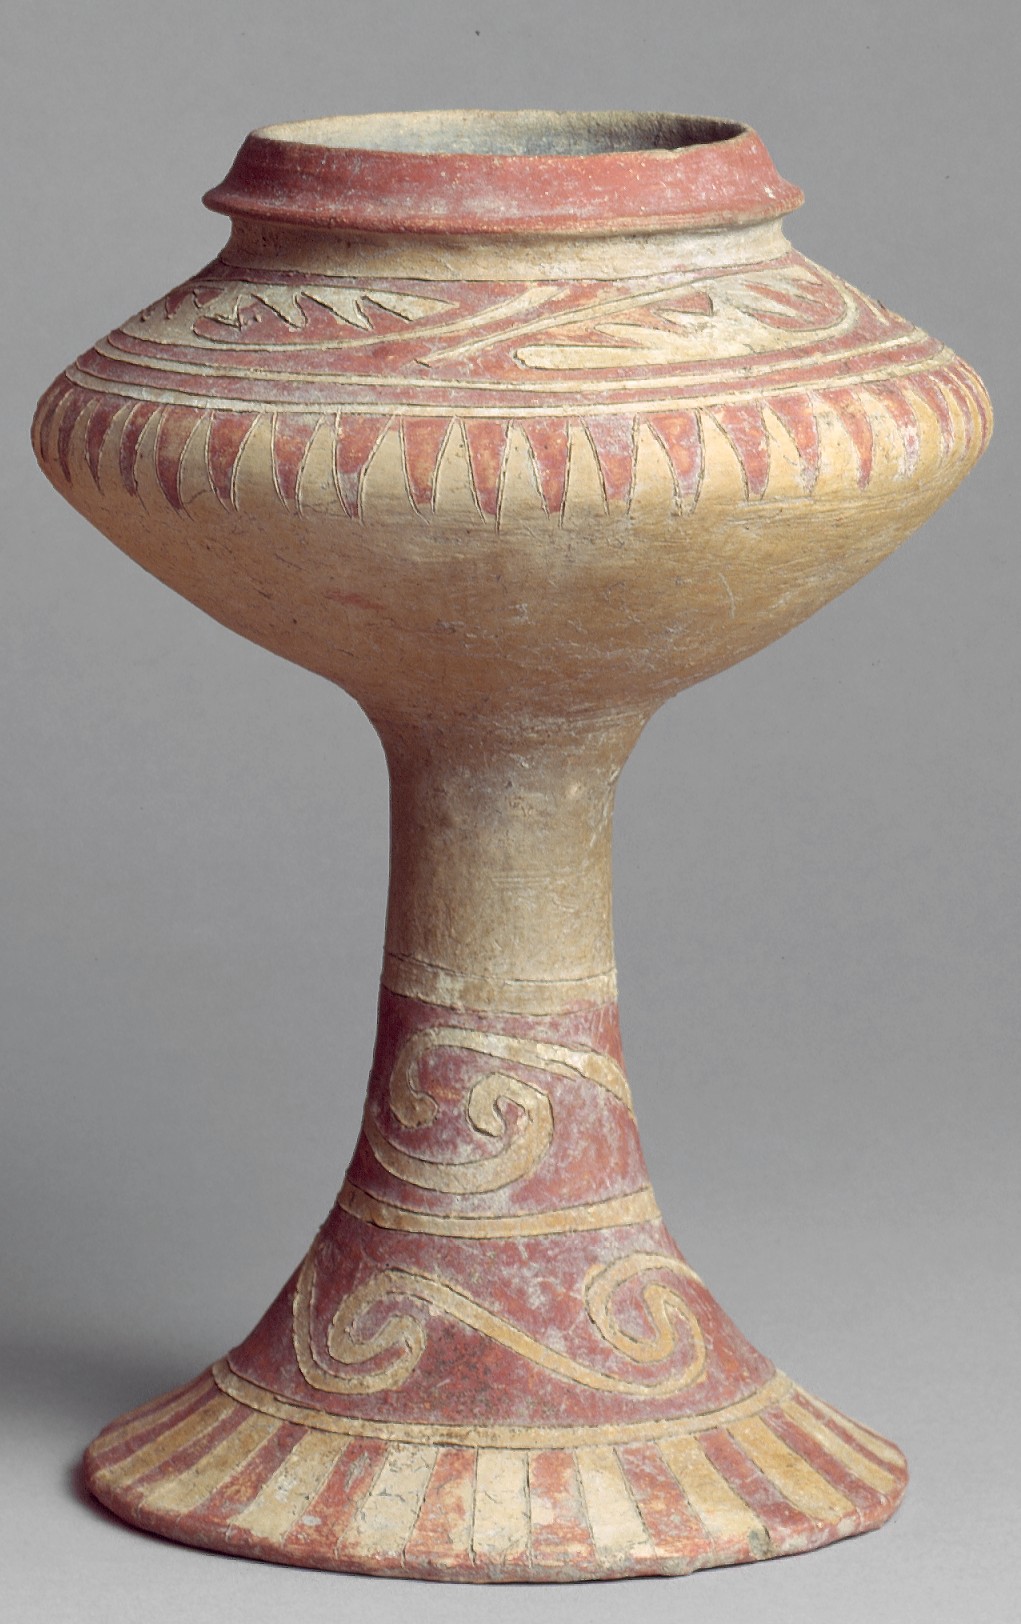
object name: vase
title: Stem Vase with Incised and Painted Design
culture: thai, ban chiang culture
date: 1000-300 BCE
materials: earthenware